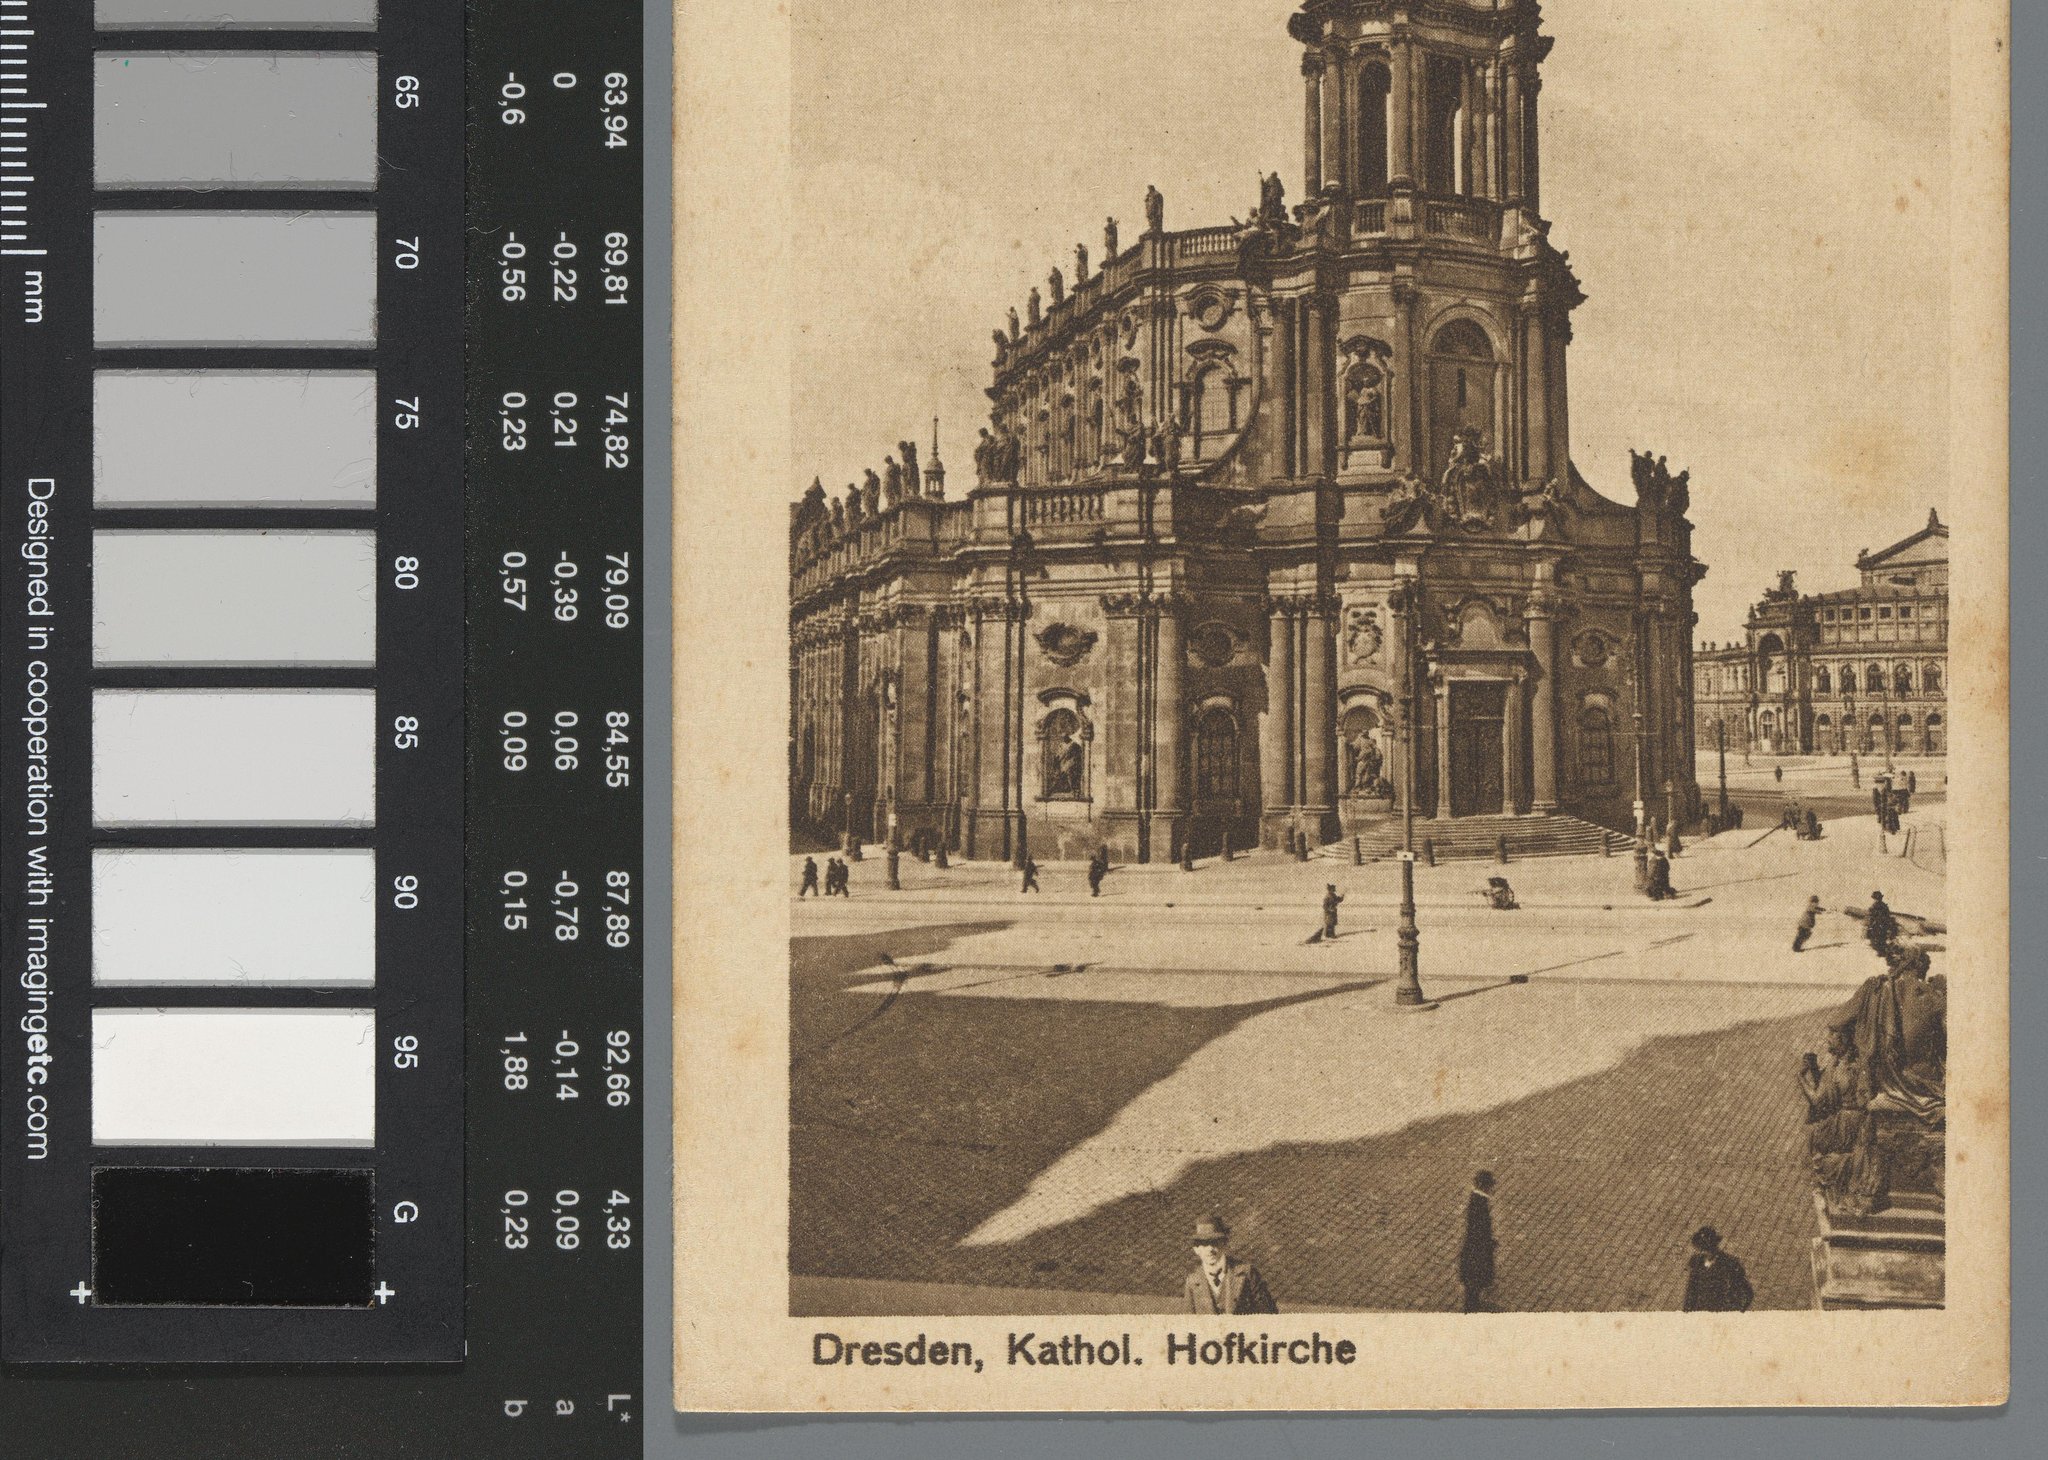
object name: postcard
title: Dresden, Kathol. Hofkirche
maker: carl a.e. schmidt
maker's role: fotograaf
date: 1920-1950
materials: photographic support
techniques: rotogravure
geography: dresden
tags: dresden